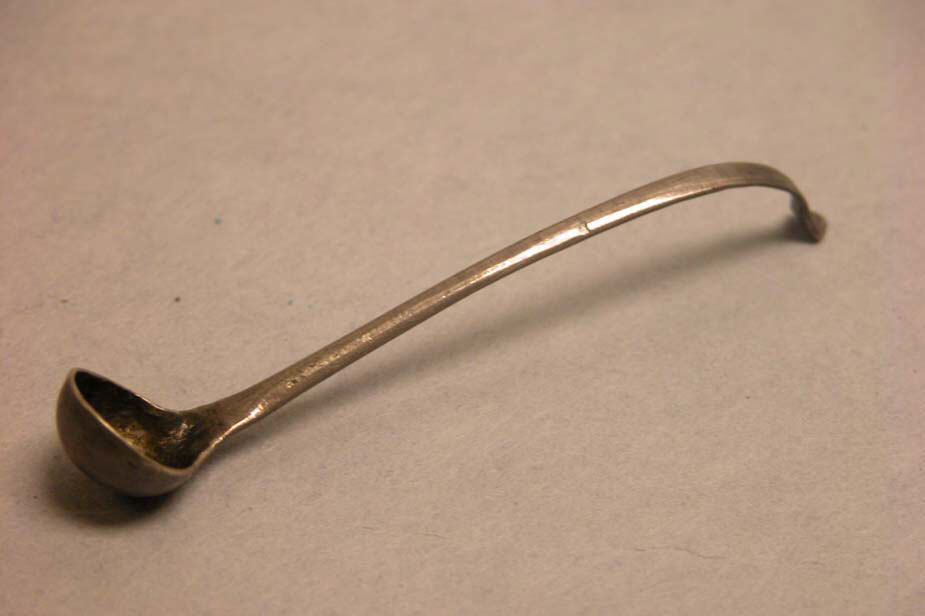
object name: ladle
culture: japanese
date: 1801-1900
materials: silver